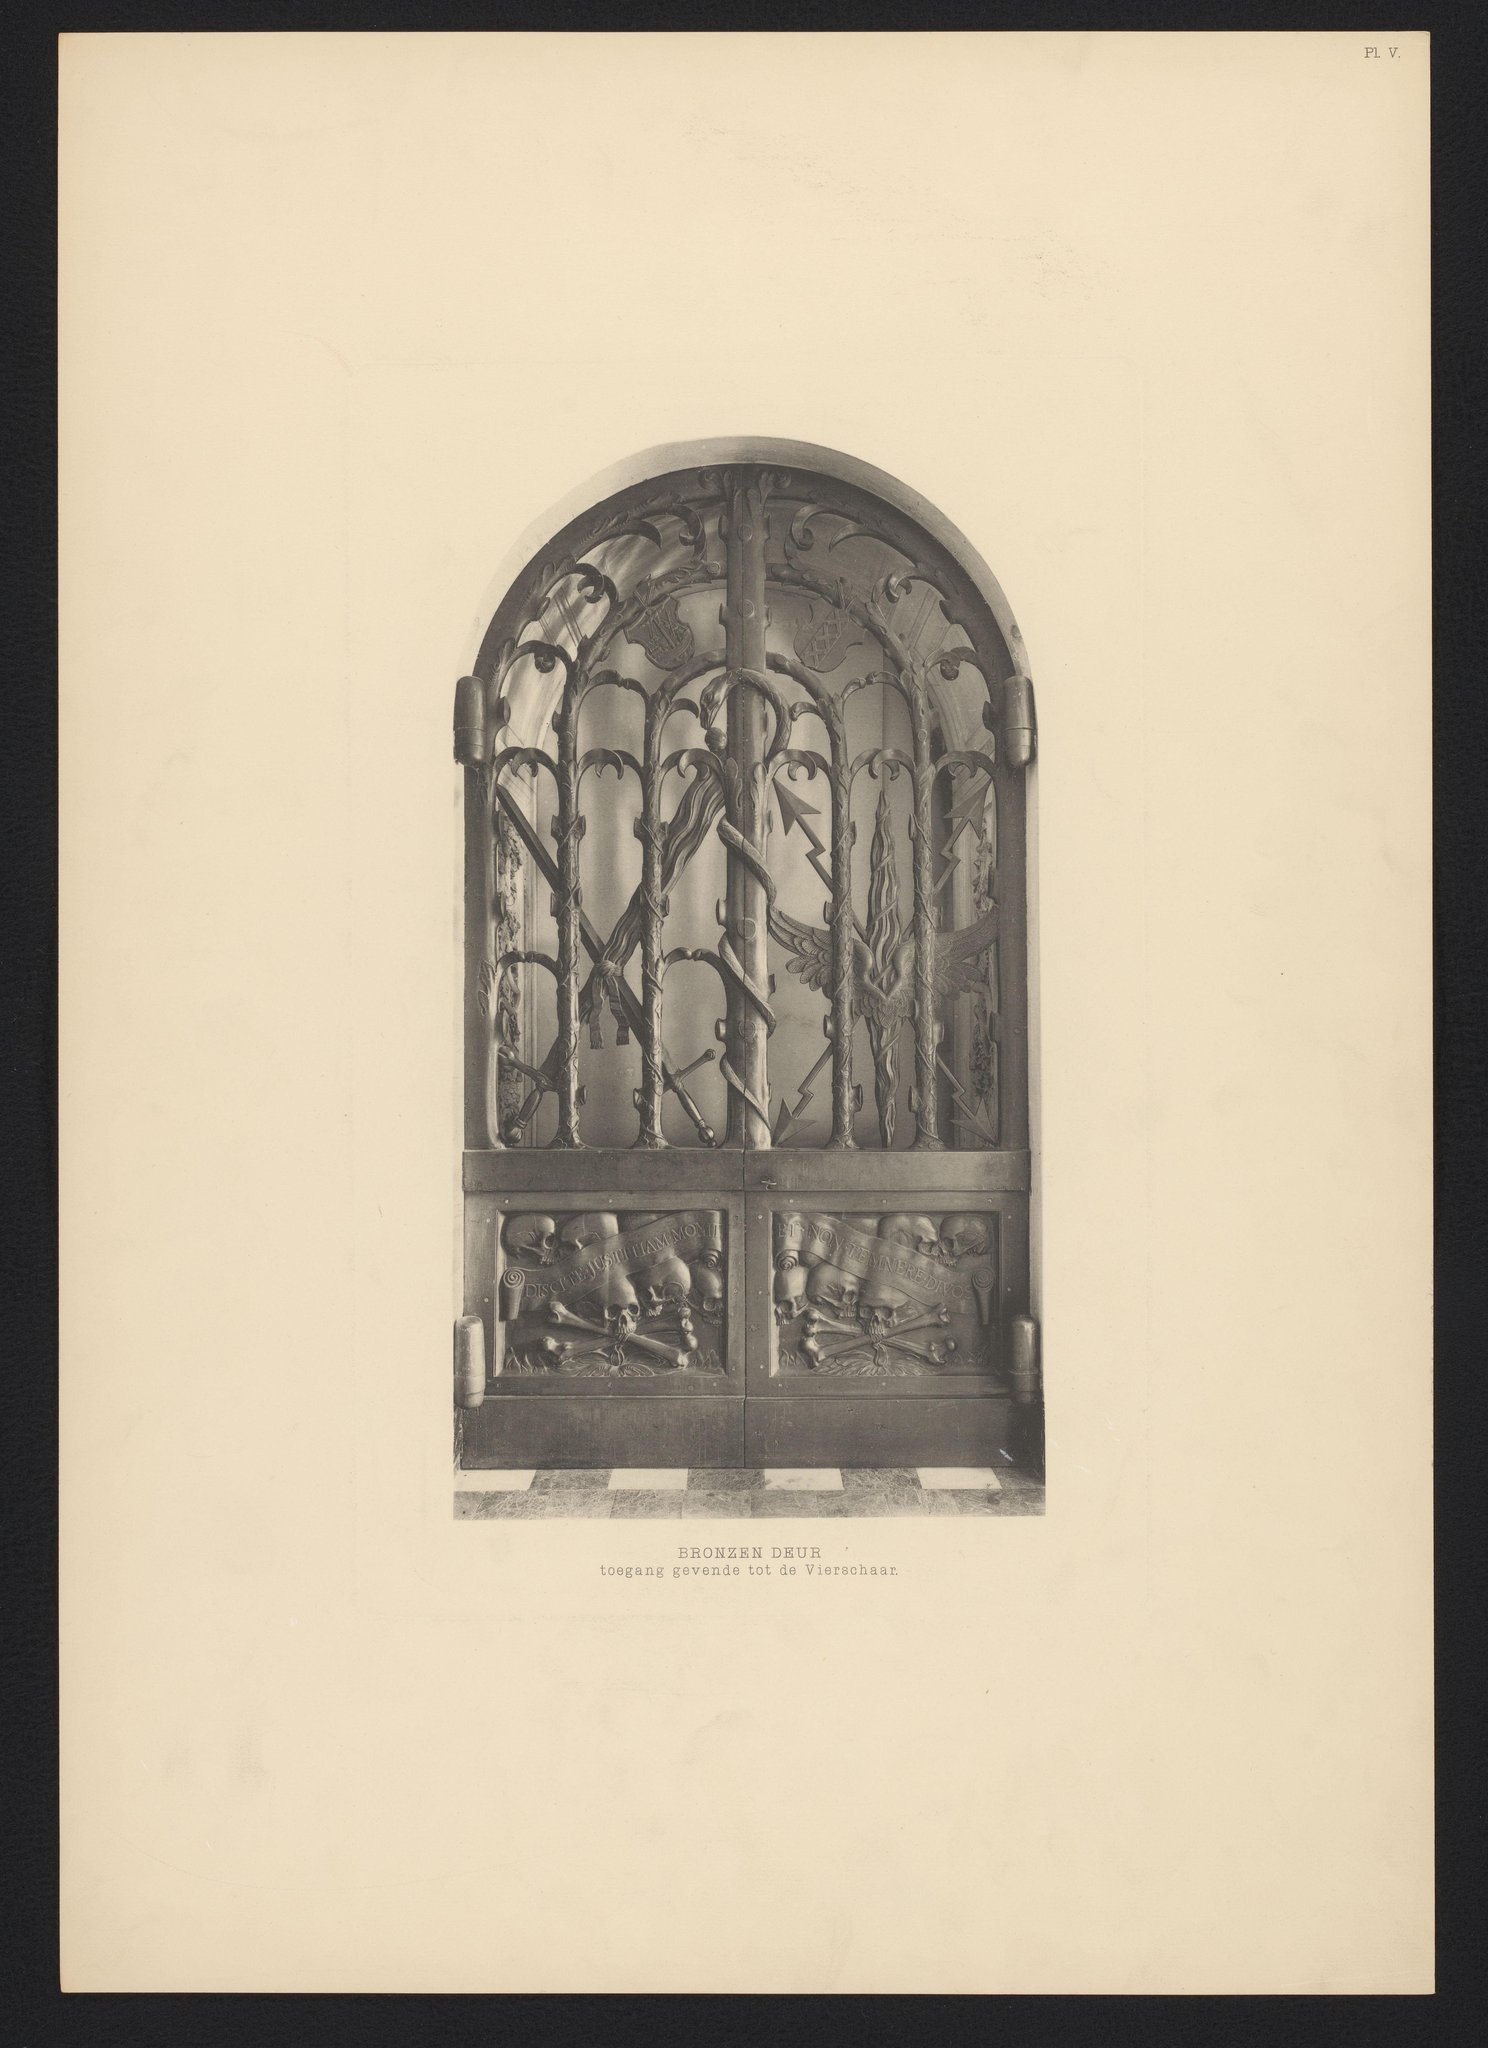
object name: photograph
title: Het Koninklijk Paleis te Amsterdam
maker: Anonymous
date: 1899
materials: cardboard, paper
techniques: photograph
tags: palace, door, royal palace of amsterdam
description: Bronzen deur / toegang gevende tot de Vierschaar.